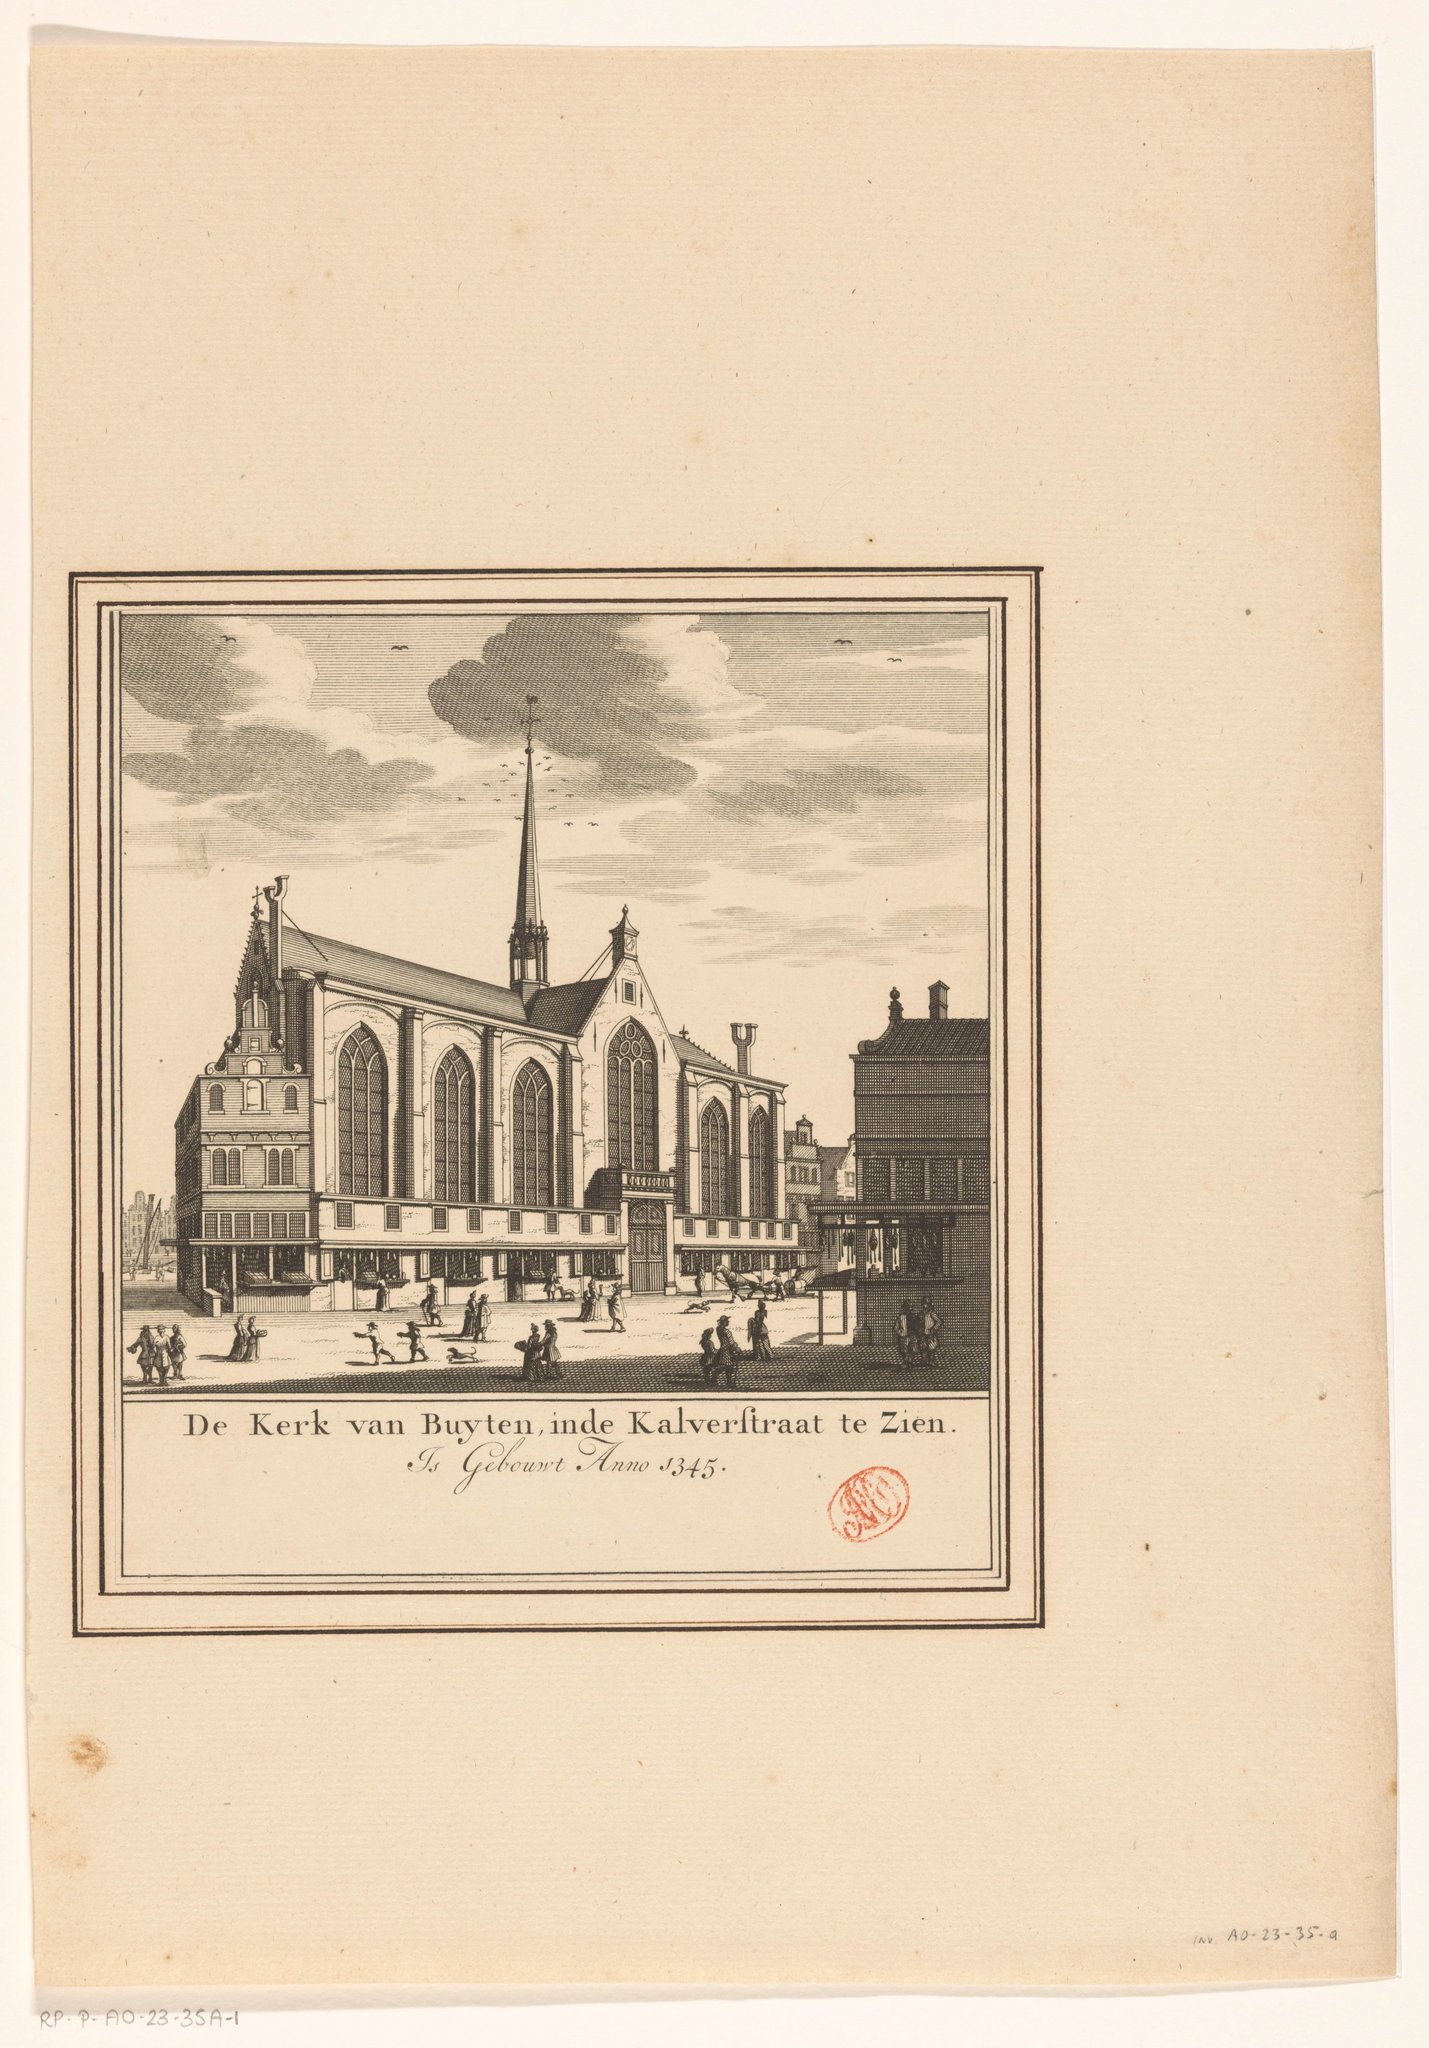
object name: print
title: Gezicht op de Heilige Stede (Nieuwezijds Kapel) te Amsterdam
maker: daniël stopendaal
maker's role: print maker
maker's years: 1672-1726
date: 1685-1726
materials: paper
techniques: engraving, etching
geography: amsterdam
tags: church (exterior) - qq - small church, chapel, street (+ city(-scape) with figures, staffage)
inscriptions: collector's mark: Lugt 195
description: Is waarschijnlijk oorspronkelijk één van de randprenten van 'Afbeeldinge vande Sitplaatsen inde Nieuwe-zyds Capel' (RP-P-1912-2295) of 'Caart vande Sitplaat-sen inde N.Z. Capel', beide plattegronden van de zitplaatsen in de Heilige Stede (Nieuwezijds Kapel). Daniël Stopendaal staat als prentmaker vermeld op de plattegronden zelf, de randprenten zijn mogelijk ook door hem gemaakt. Zie RP-P-AO-23-35B, RP-P-AO-23-36A en RP-P-AO-23-36B voor andere bijhorende randprenten. Zie RP-P-AO-23-57 voor een soortgelijke plattegrond van de Oosterkerk met randprenten.